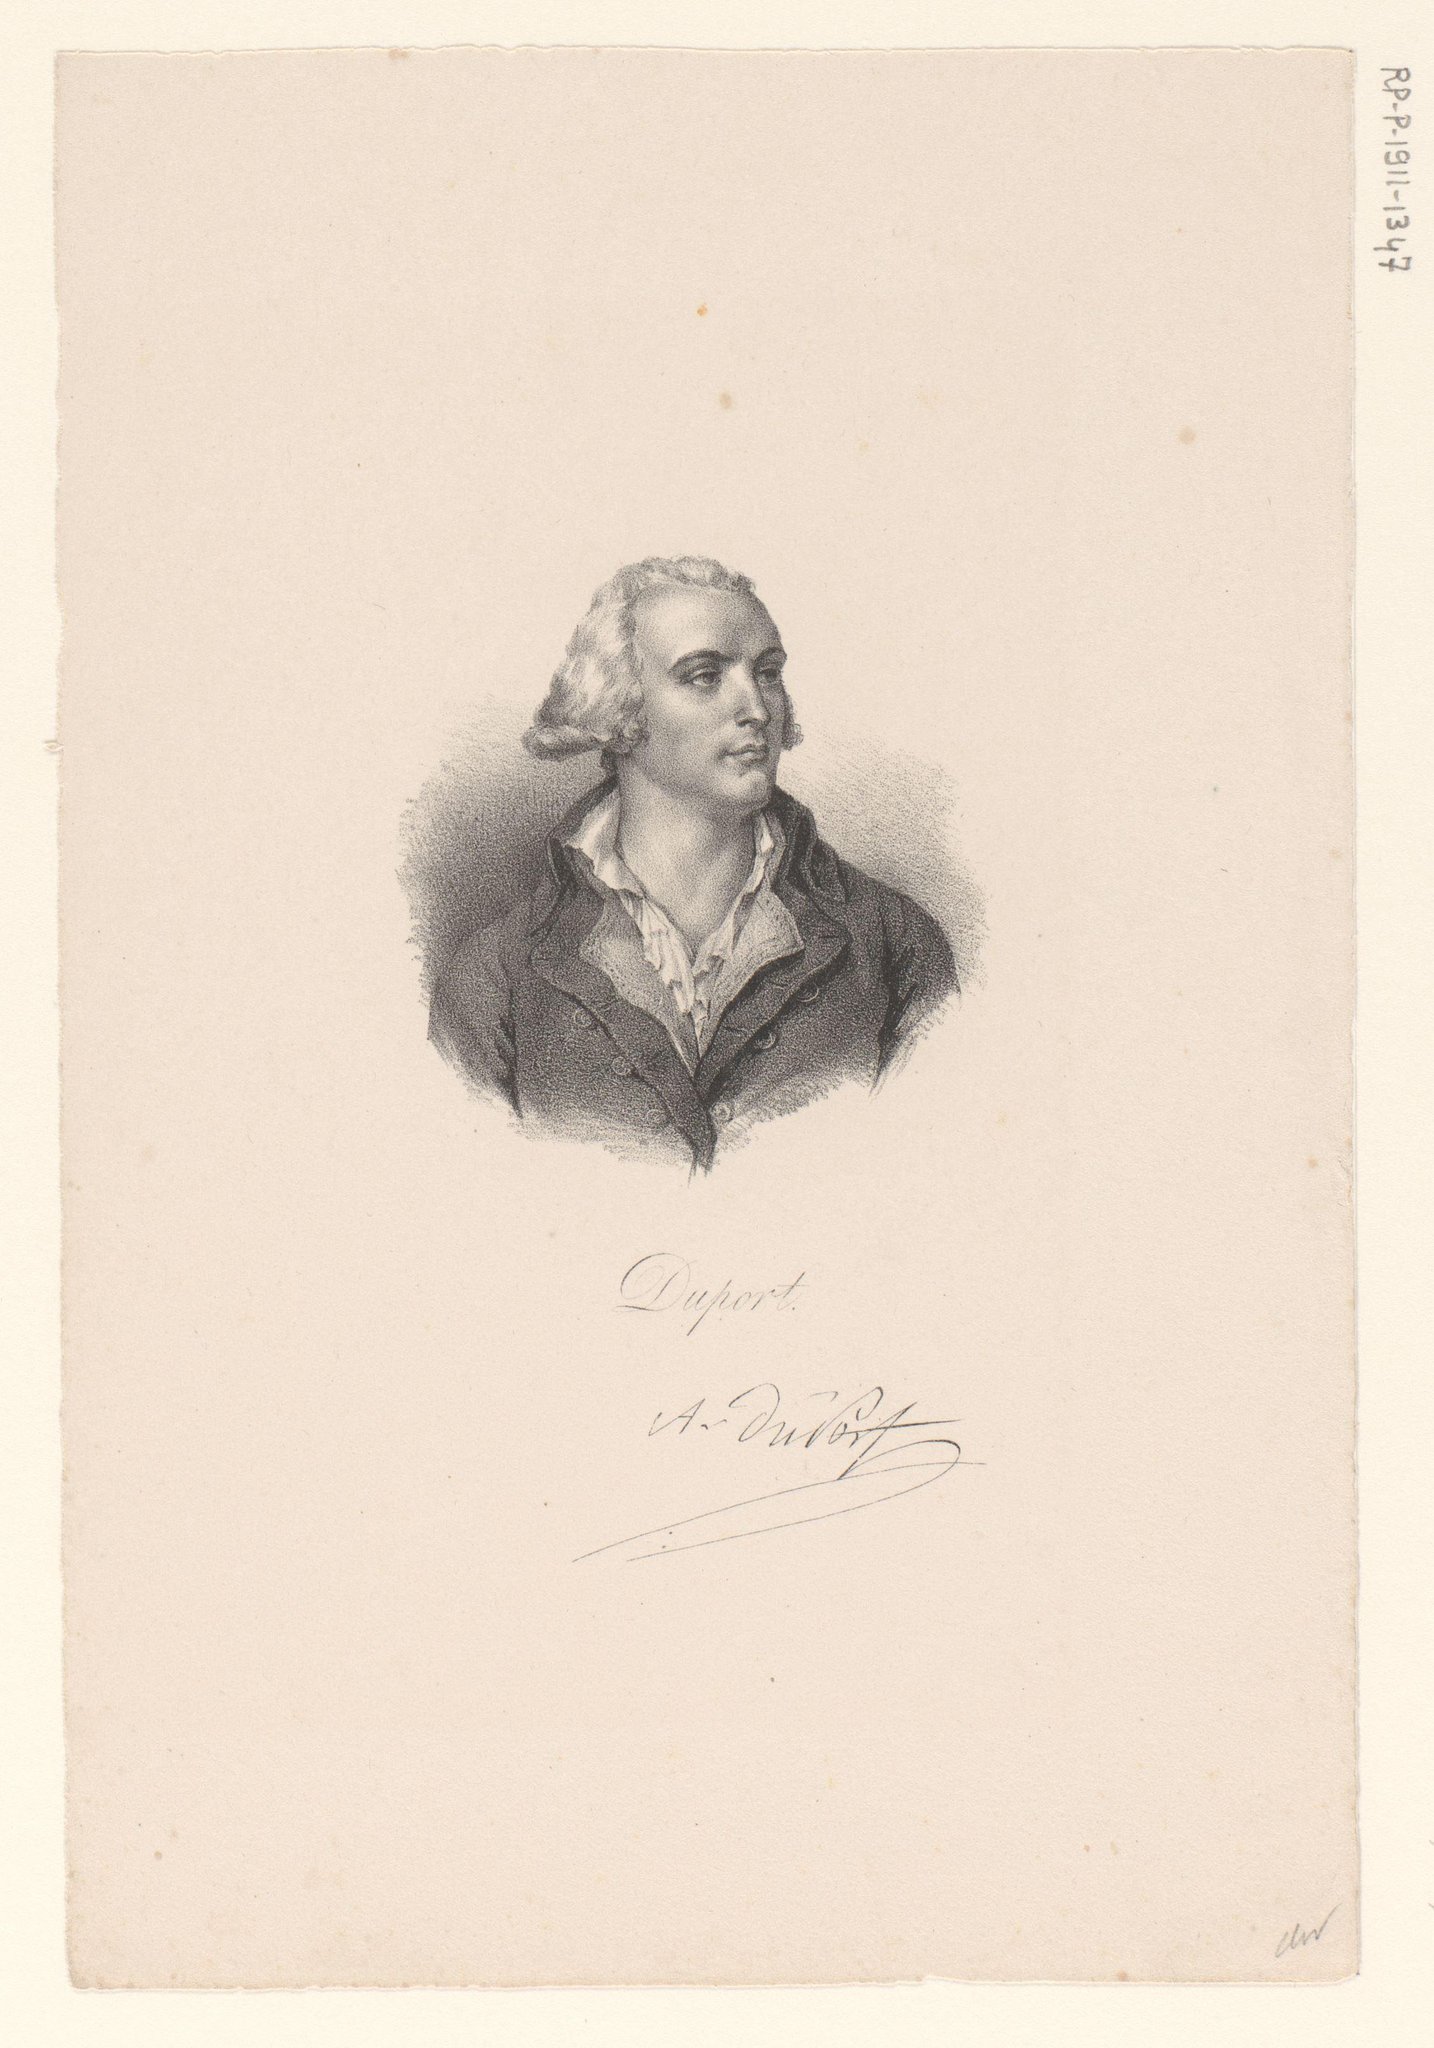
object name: print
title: Duport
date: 1818-1842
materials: paper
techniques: lithograph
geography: paris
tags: politician, historical persons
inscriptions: collector's mark: Lugt 2228a